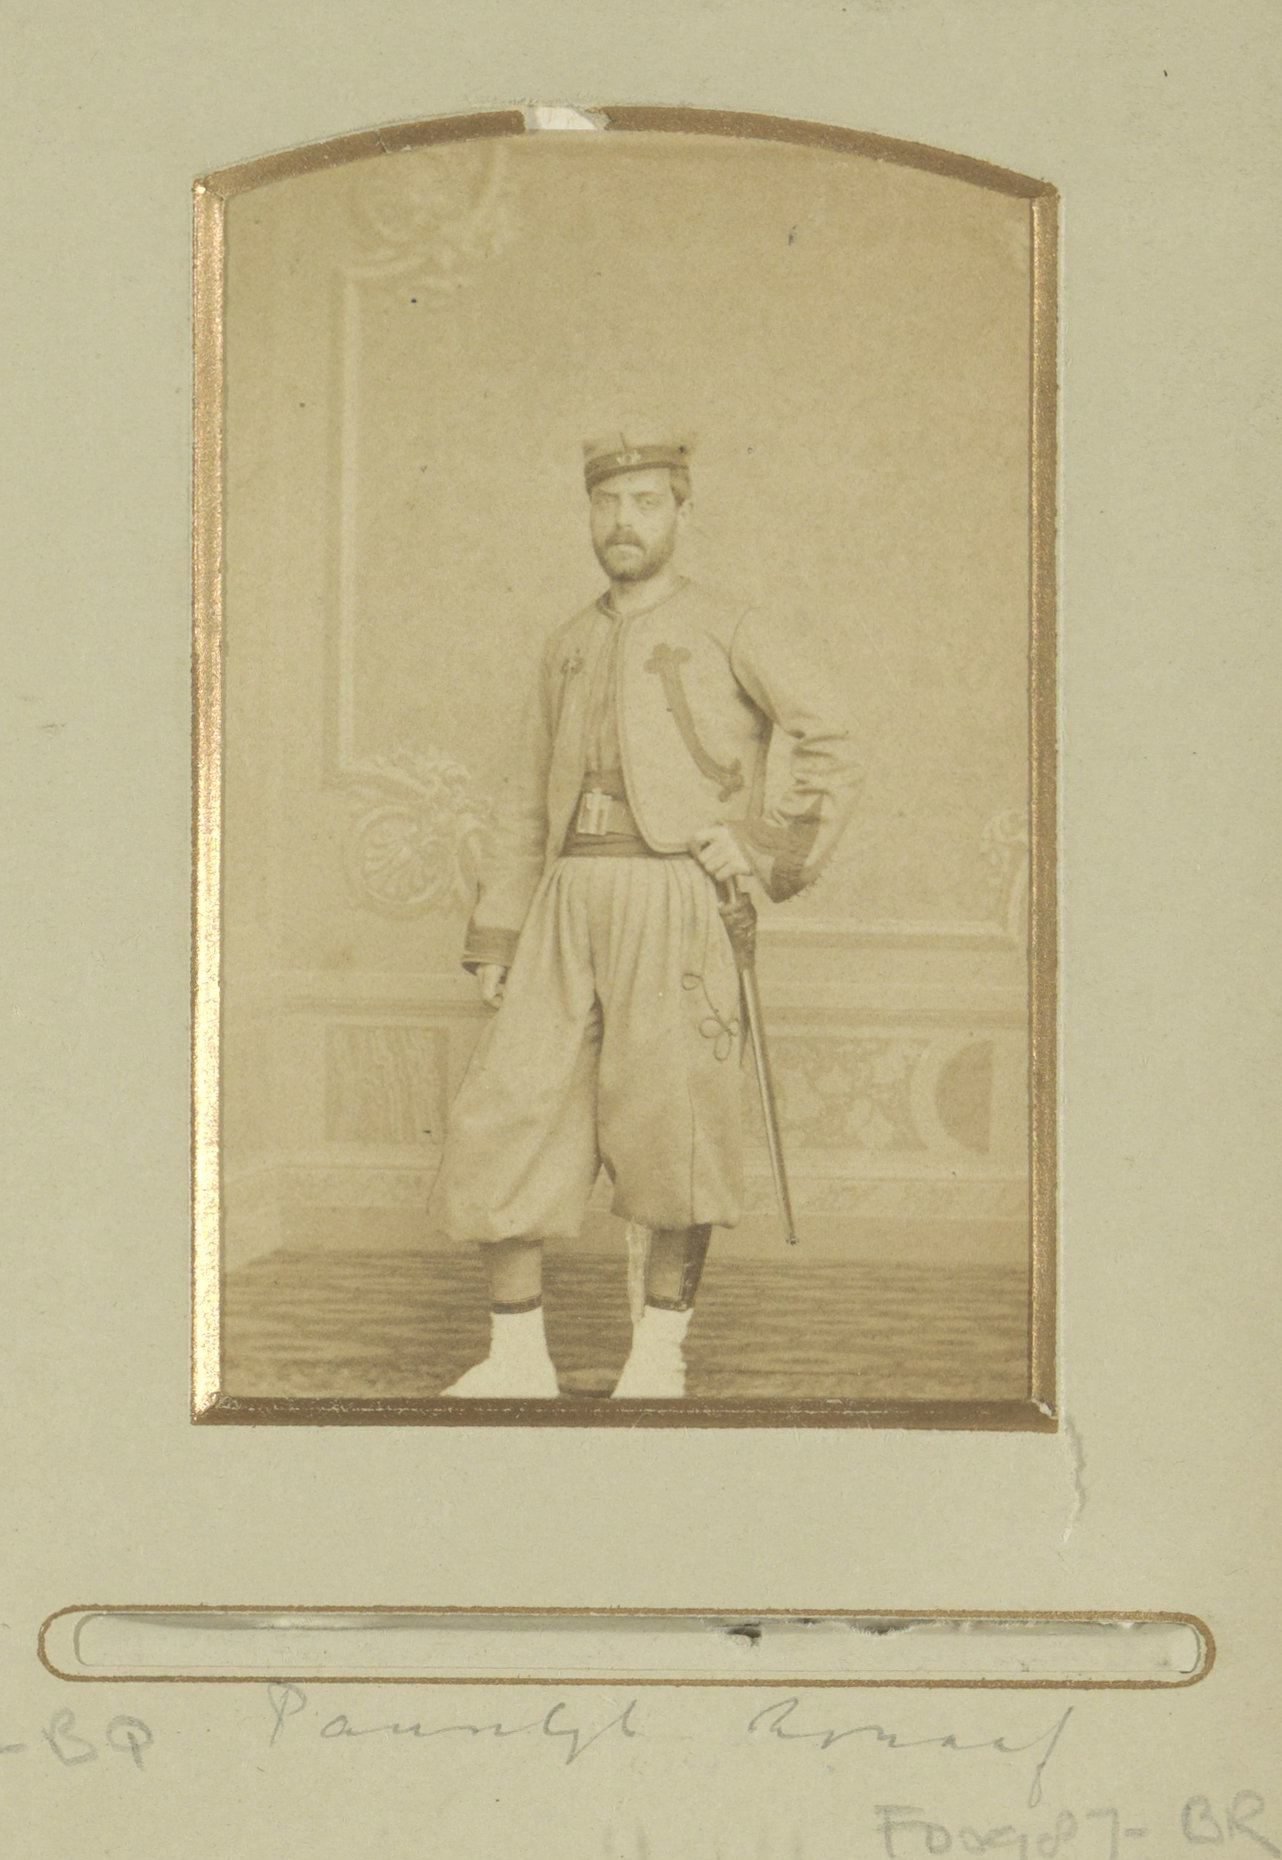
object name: carte de visite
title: Portret van een (vermoedelijk) Italiaanse zoeaaf, staand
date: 1861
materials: cardboard, paper, photographic support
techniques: albumen print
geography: rome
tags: studio requisites ~ photographer, warfare; military affairs, (military) uniforms, division of armed forces, rome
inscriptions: inscription: ‘à [...]avier de Regnon Son camarade [...] zouaves Pontificau [...] le 14 juin 1861’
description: Onderdeel van Album met cartes-de-visite en kabinetfoto's van militairen in uniform.